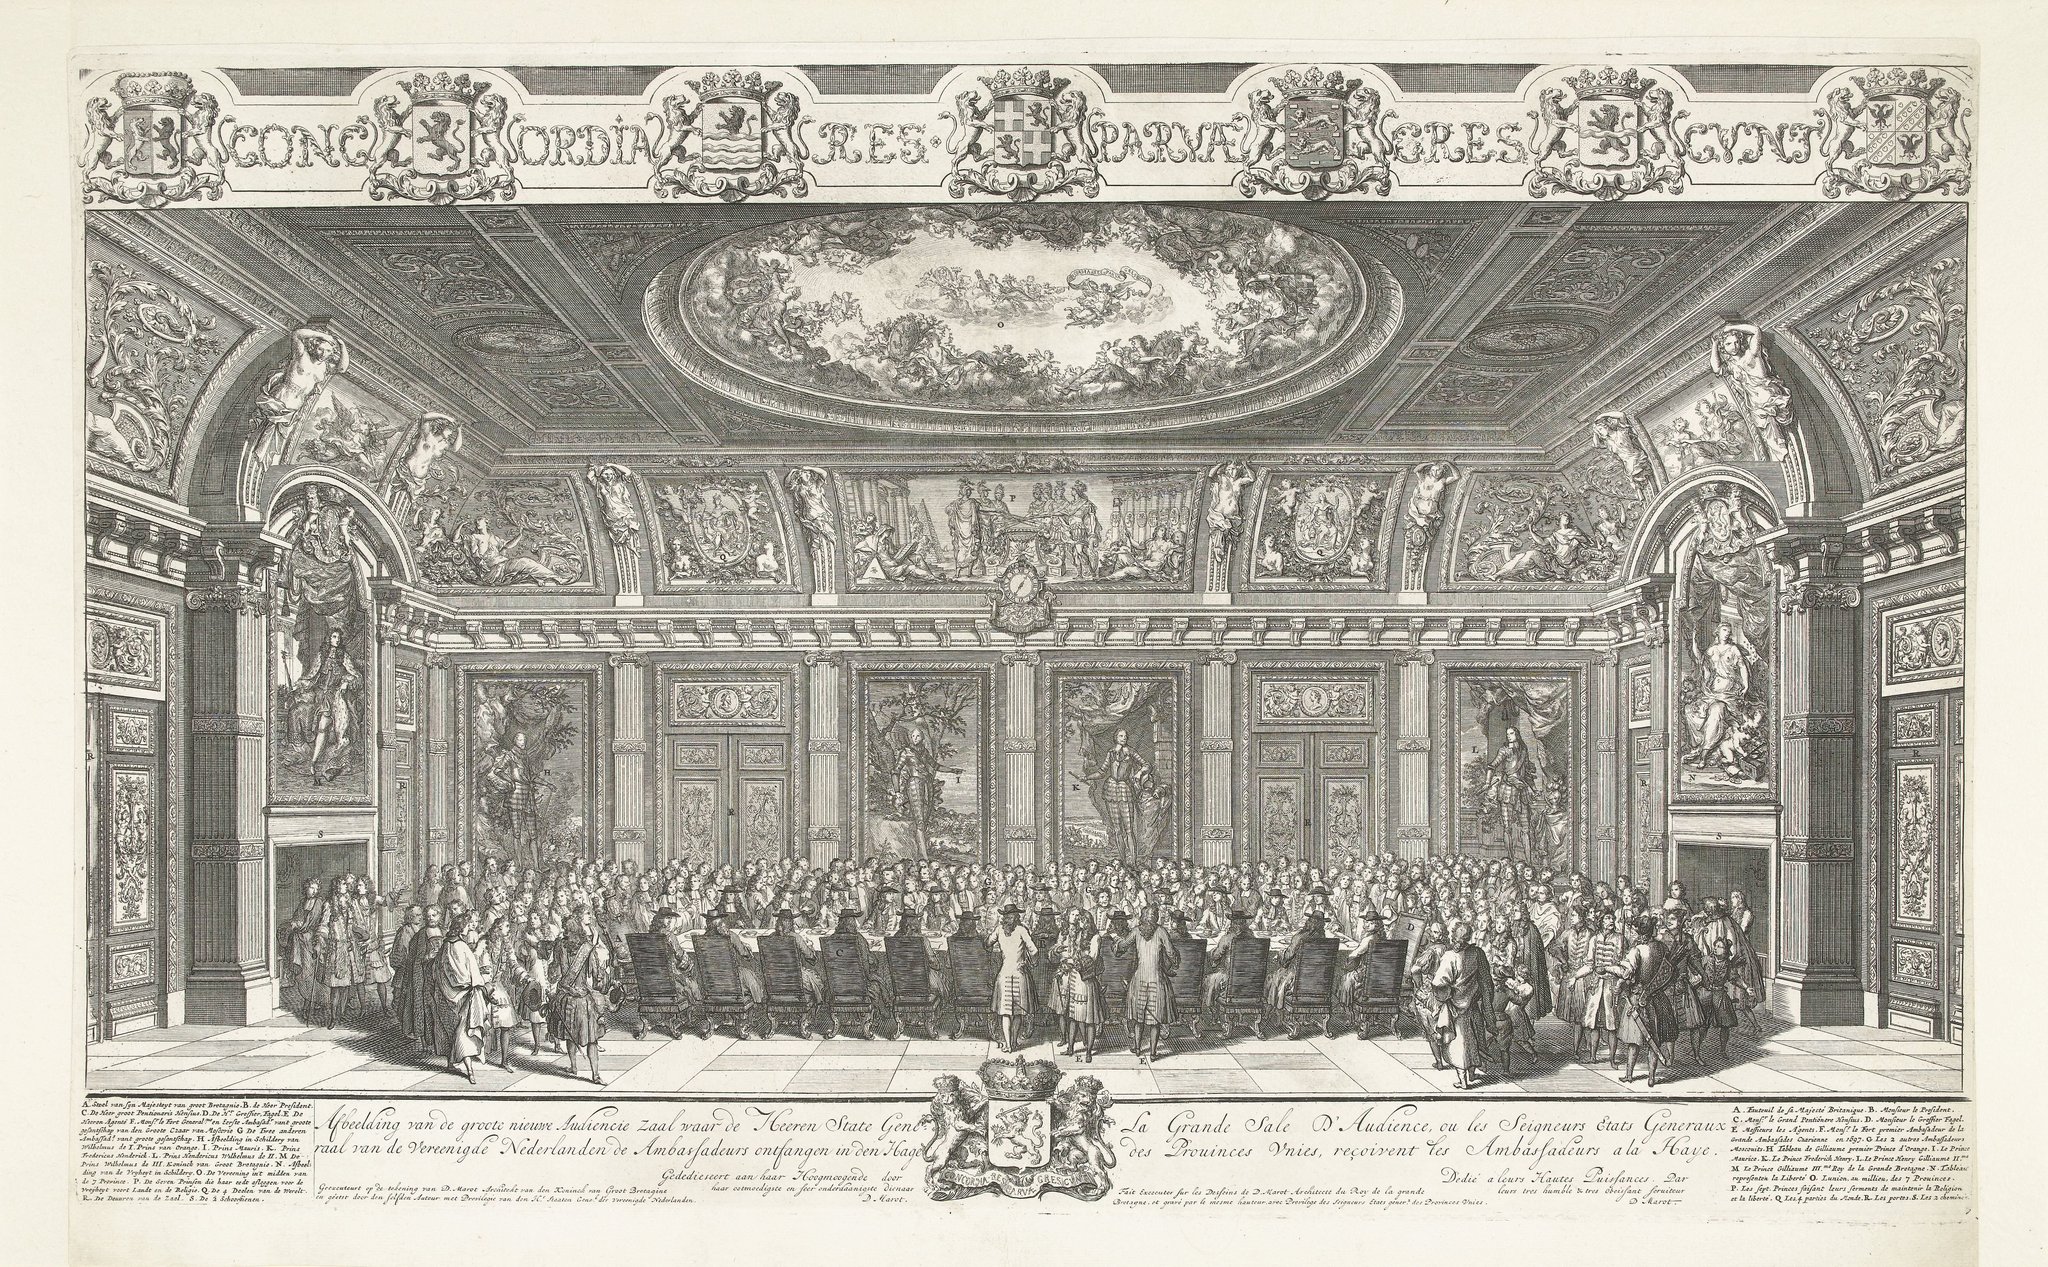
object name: print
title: Afbeelding van de groote nieuwe Audiencie Zaal waar de Heeren State Generaal van de Vereenigde Nederlanden de ambassadeurs ontfangen in Den Hage / La Grande Sale d'Audience, ou les Seigneurs Etats Generaux des Provinces Unies, reçoivent les ambassadeurs a La Haye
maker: daniël marot (i)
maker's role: draughtsman, print maker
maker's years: 1661-1752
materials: paper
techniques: engraving, etching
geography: the hague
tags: coat of arms (as symbol of the state, etc.) (+ city; municipal), ceremony ~ putting a building into use, assembly-room, coat of arms (as symbol of the state, etc.) (+ nation; national), reception ~ ambassador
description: De Trêveszaal, de nieuwe audiëntiezaal waar de Staten-Generaal buitenlandse ambassadeurs ontvangt, in gebruik genomen in oktober 1697. De zaal is vol met leden van de Staten-Generaal en verschillende buitenlandse gezanten. Aan de wanden schilderijen met portretten van stadhouders en allegorische voorstellingen. Met onderschrift en legenda A-S in het Nederlands en Frans. Bovenaan de zeven wapens van de provincies, onderaan in het midden het wapen van de Staten-Generaal.